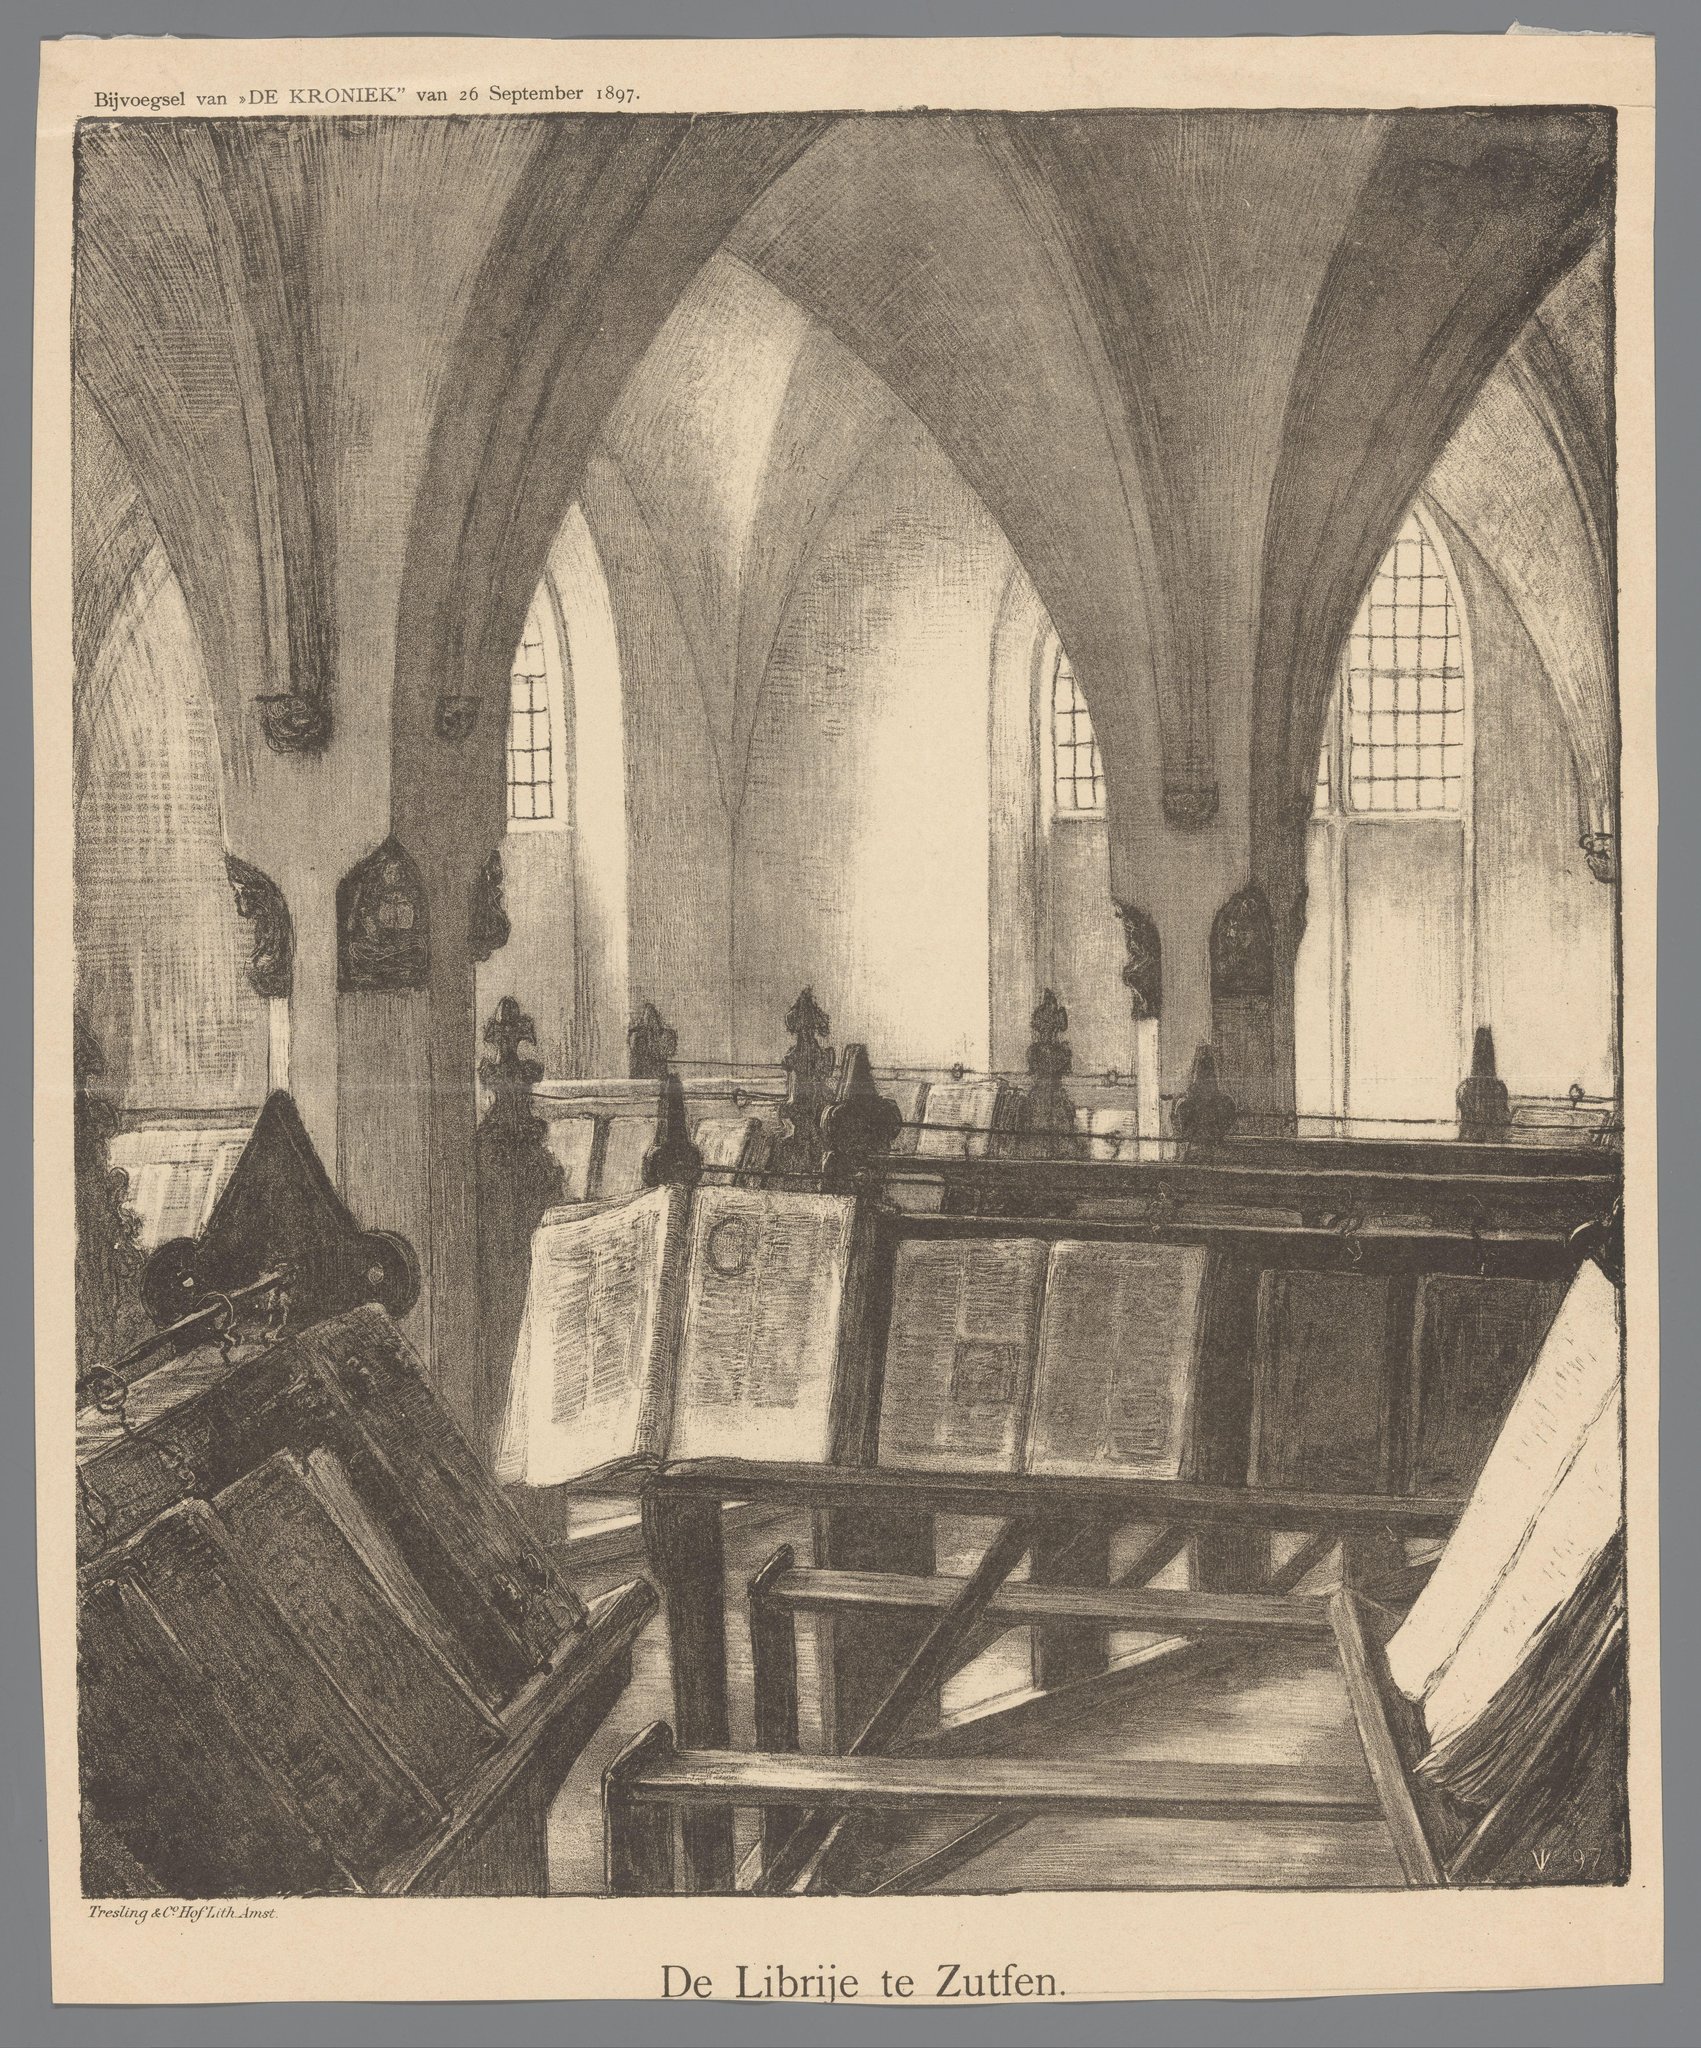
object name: print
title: Gezicht op het interieur van de Librije te Zutphen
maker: jan veth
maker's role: designer, draughtsman, painter, print maker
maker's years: 1864-1925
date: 1897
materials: paper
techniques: lithograph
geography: amsterdam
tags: book - mm - book open, public library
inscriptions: collector's mark: Lugt 2228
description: Deze prent werd uitgegeven als bijvoegsel bij De Kroniek op 26 september 1897.